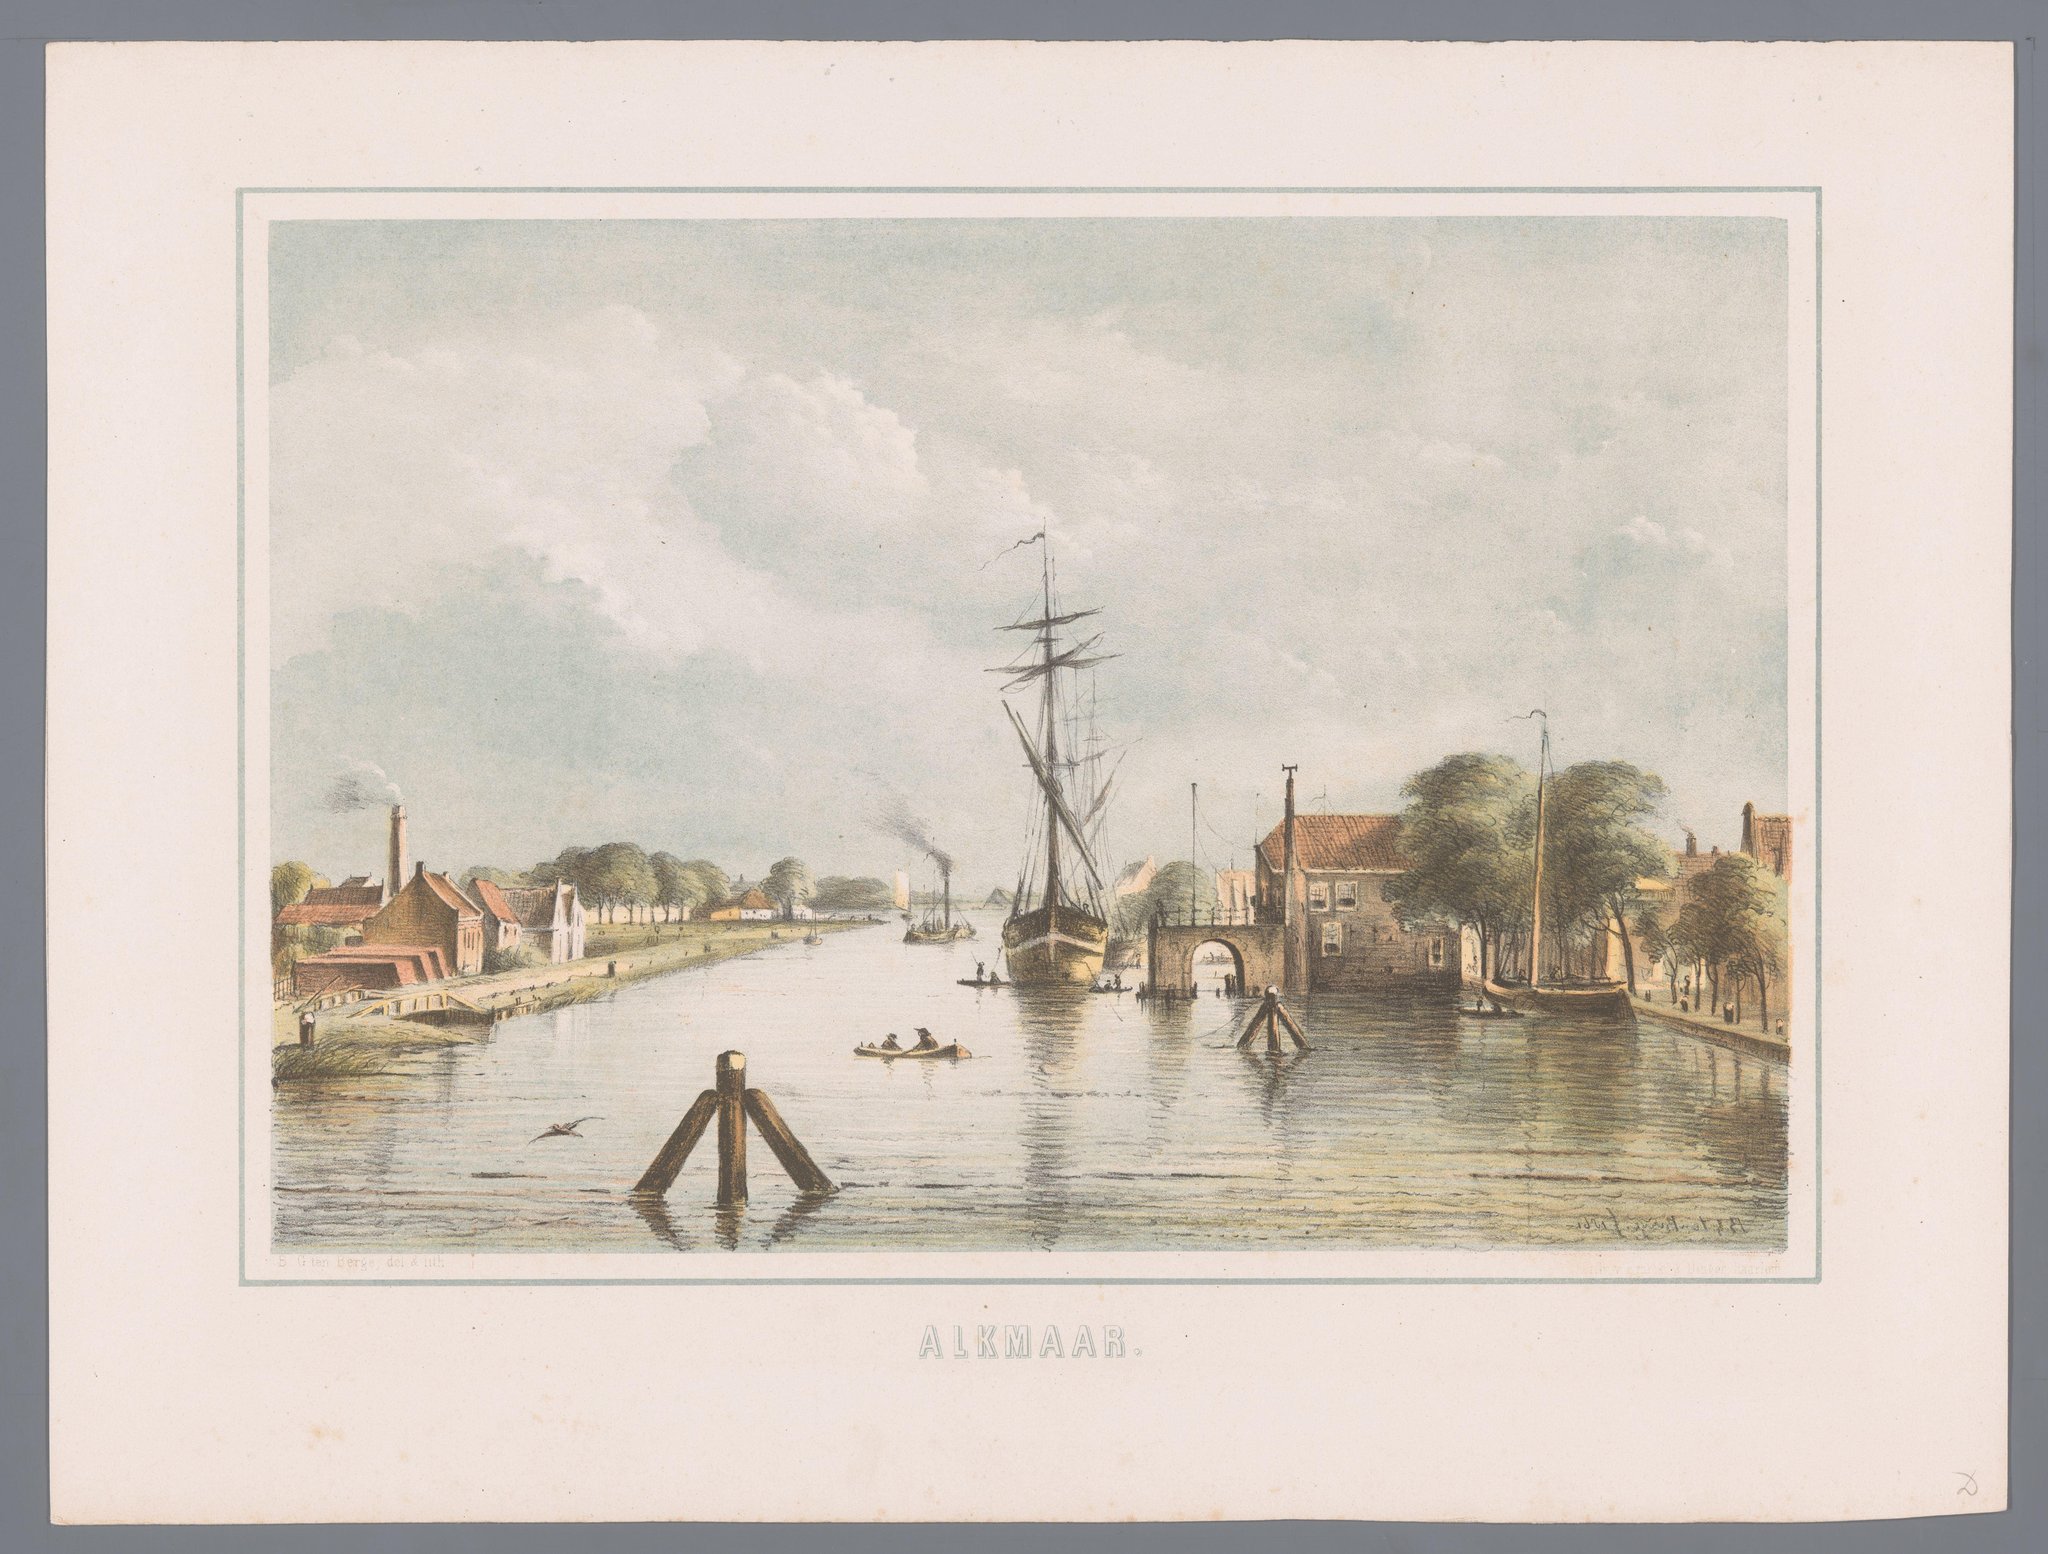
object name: print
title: Stadsgezicht te Alkmaar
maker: bernardus gerardus ten berge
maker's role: draughtsman, print maker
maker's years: 1835-1875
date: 1845-1875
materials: paper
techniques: lithograph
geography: haarlem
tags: city-view, and landscape with man-made constructions, canals, waters (in city)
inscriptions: collector's mark: Lugt 2228